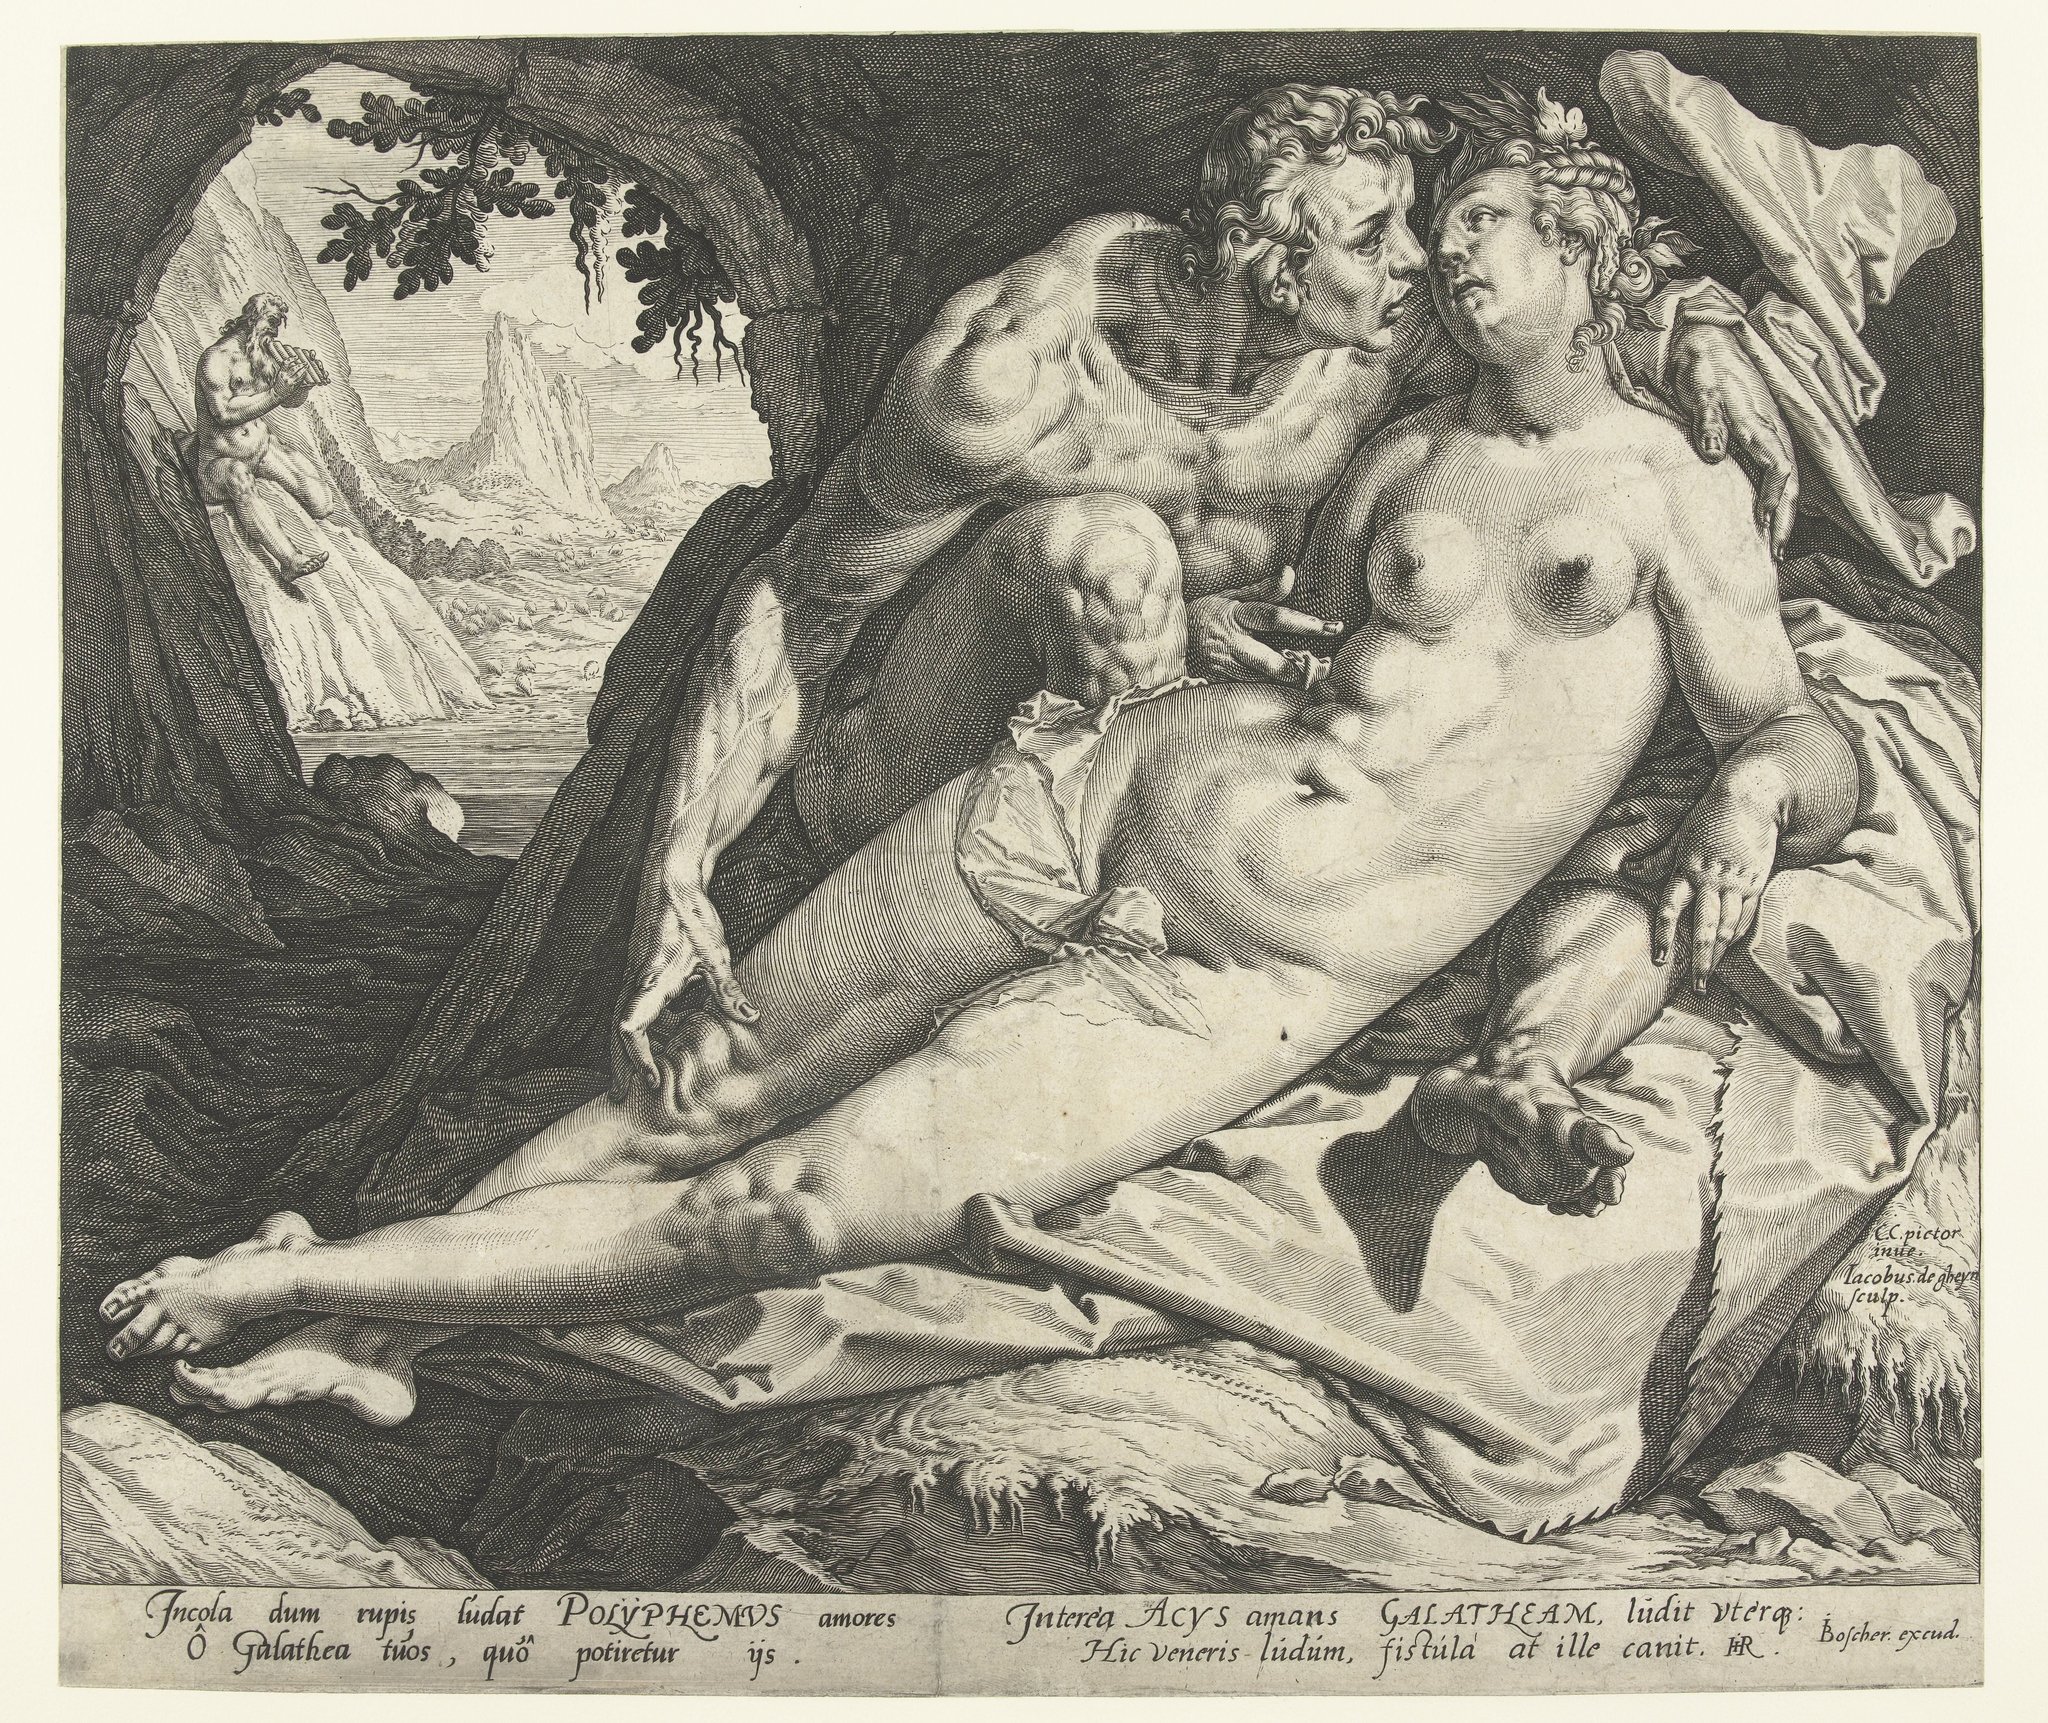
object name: print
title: Acis en Galatea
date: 1587-1591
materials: paper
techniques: engraving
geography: netherlands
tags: triumph of galatea, polyphemus playing the syrinx, acis wooing galatea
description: Een vrijwel naakte jonge vrouw (Galatea) laat zich, gelegen in een grot, betasten door een naakte jongeman (Acis). Op de achtergrond een panfluitspeler op een rots (de cycloop Polyphemus) in een bergachtig kustlandschap. Onder de voorstelling een vierregelige Latijnse tekst.